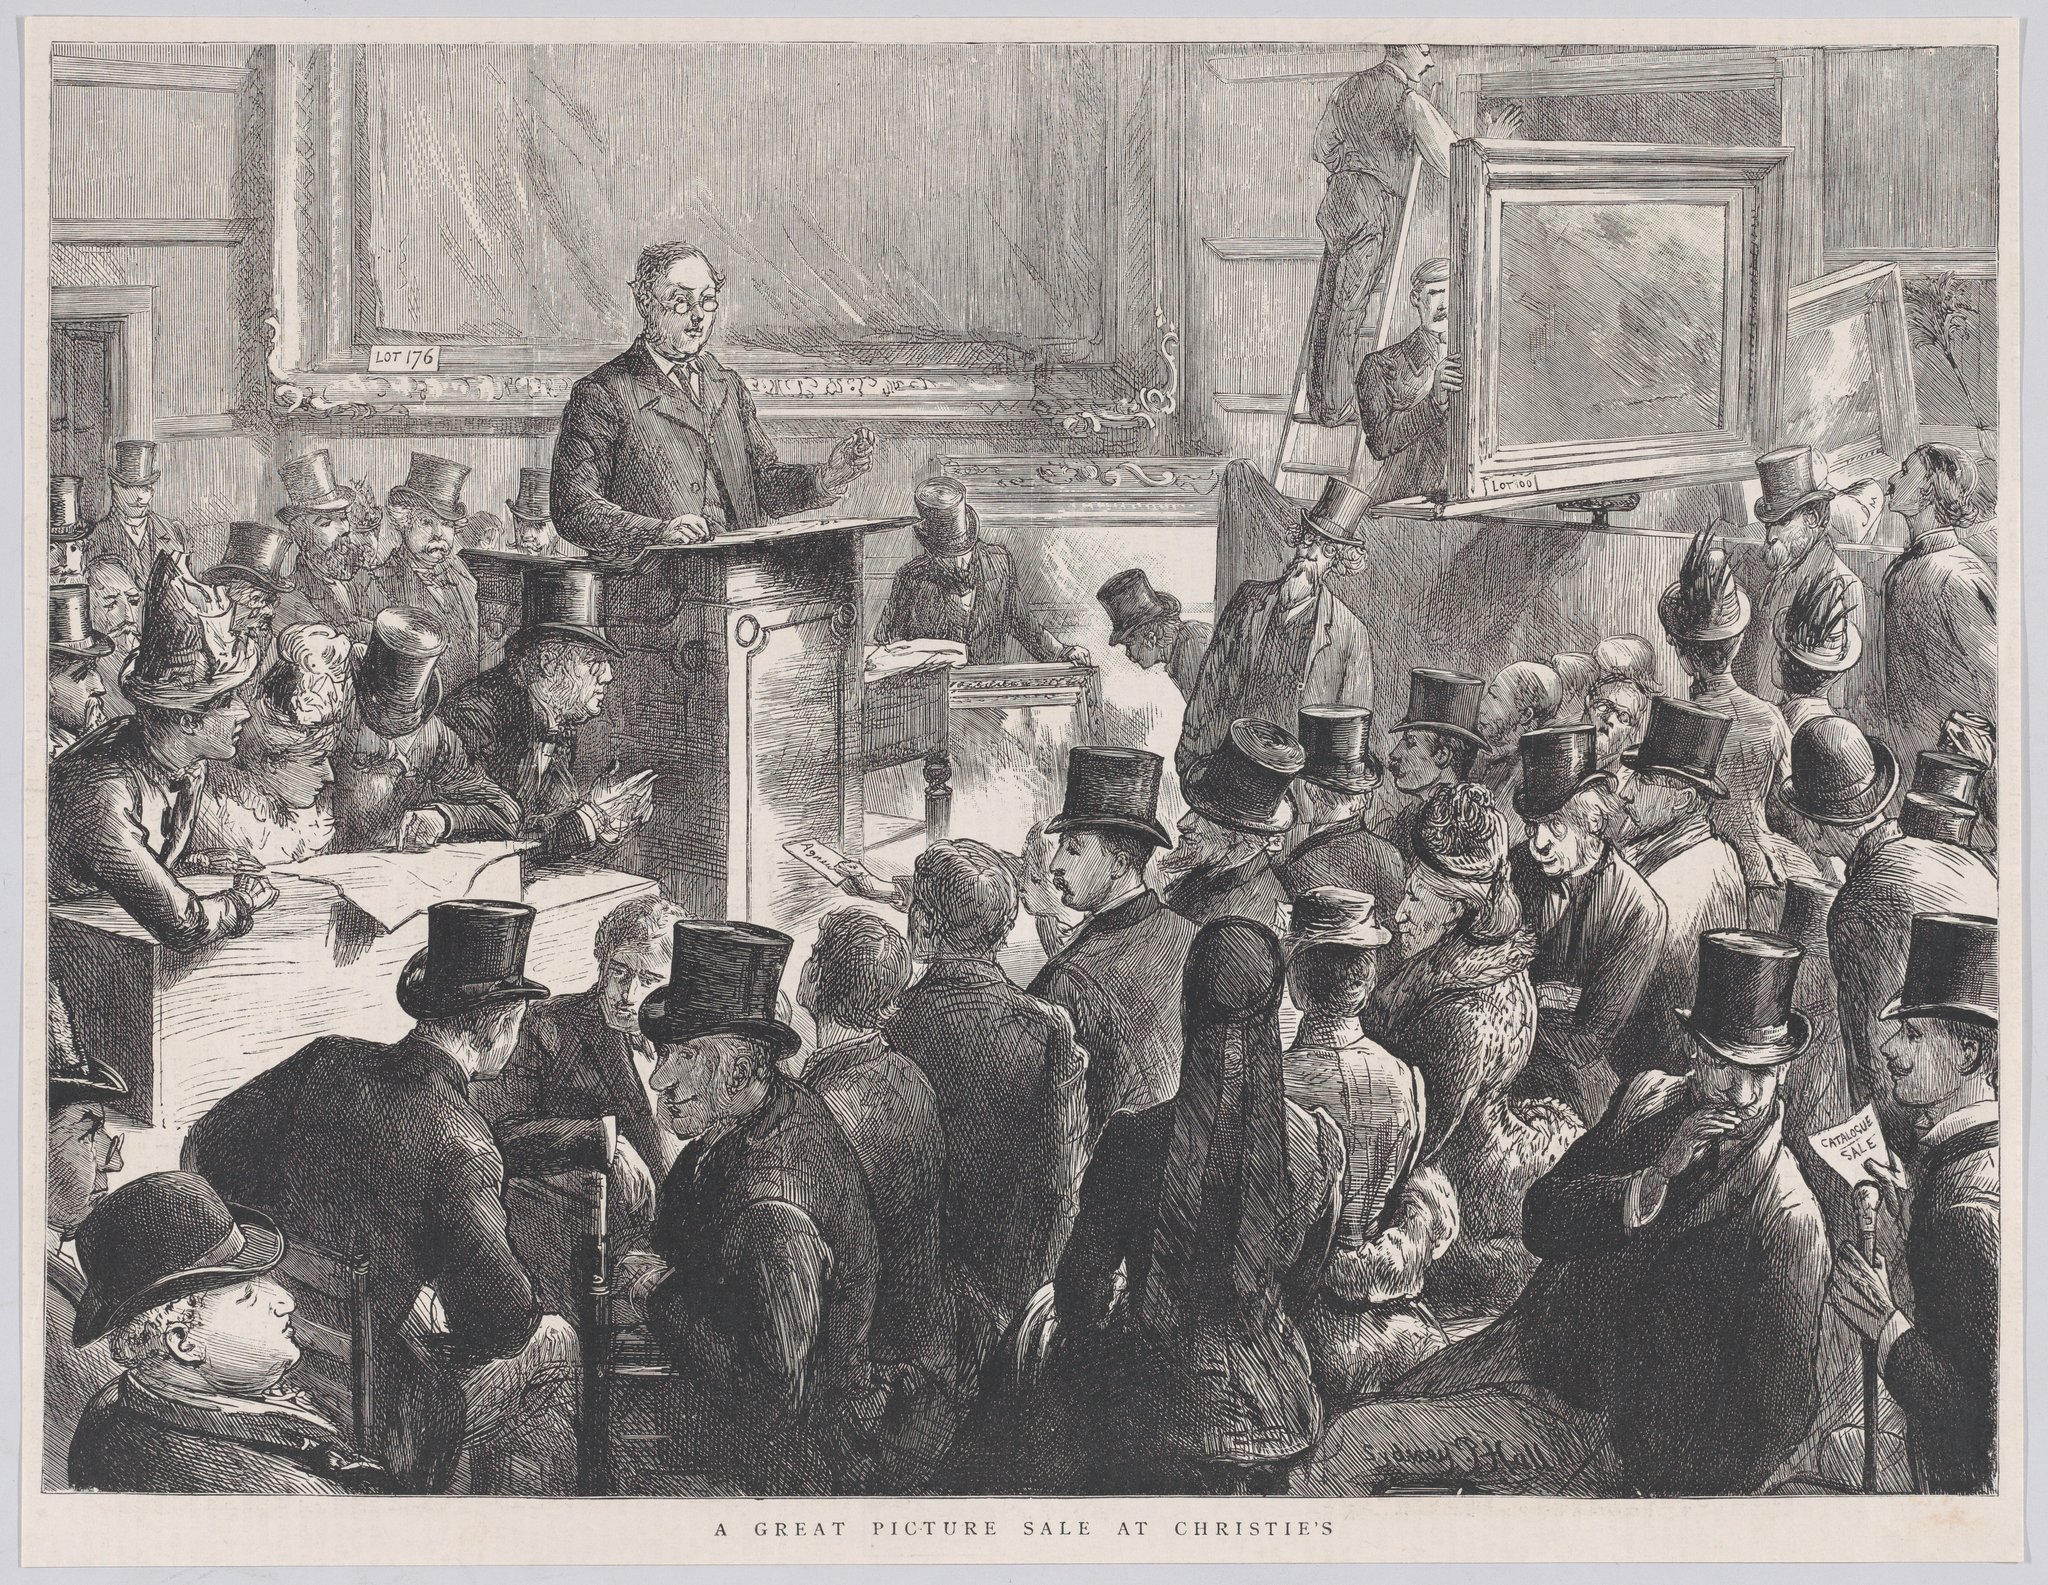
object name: print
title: A Great Picture Sale at Christie's, from "The Graphic"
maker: sydney prior hall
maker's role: artist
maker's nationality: british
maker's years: 1842-1922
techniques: engraving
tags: painting,men,women